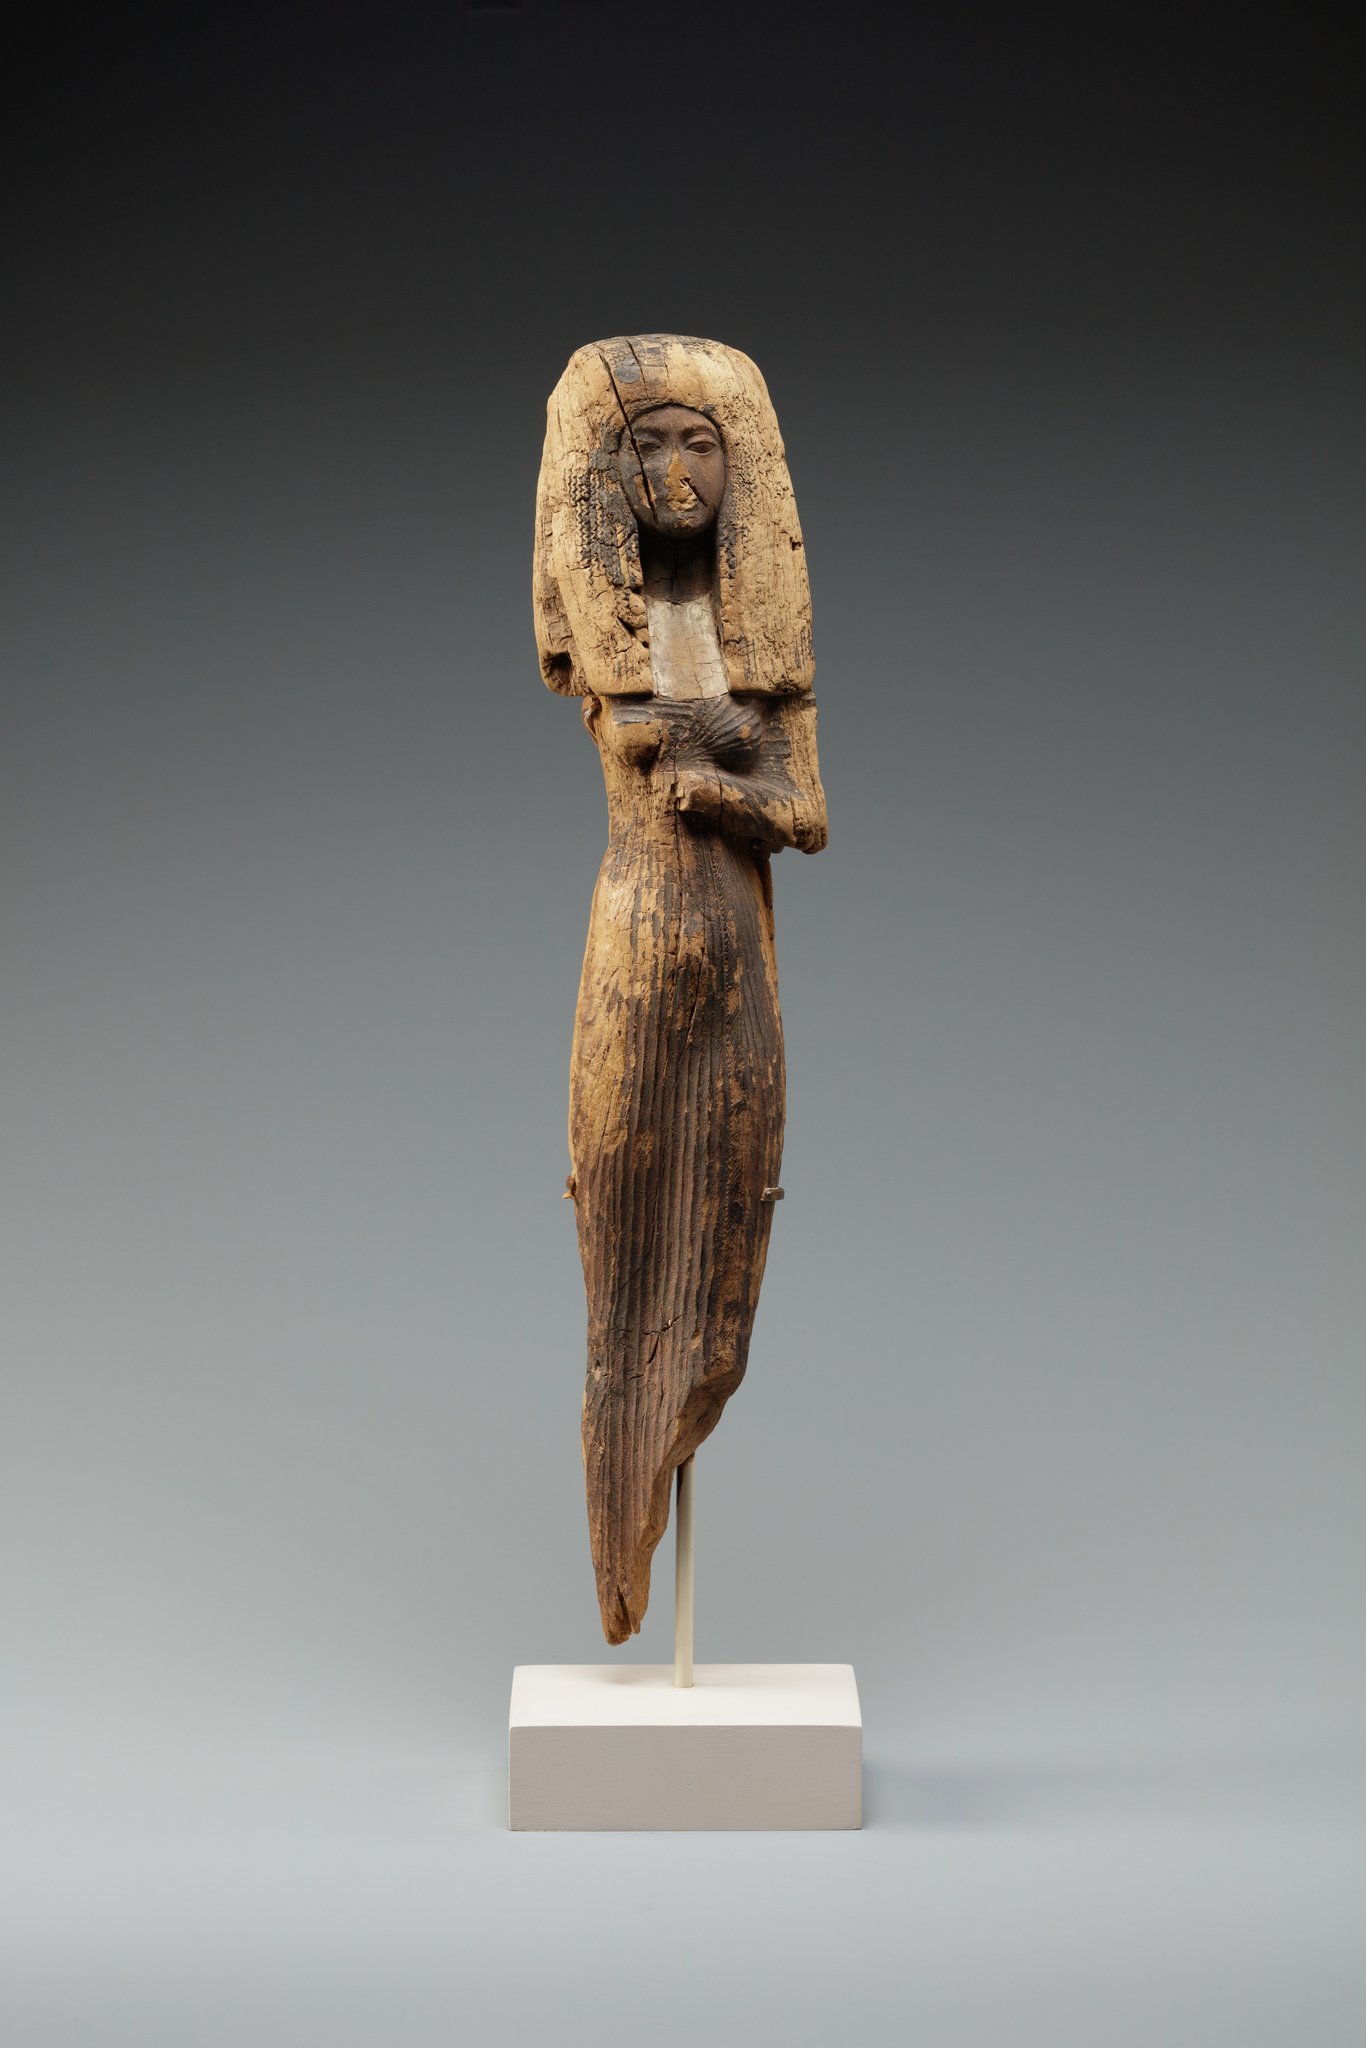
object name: statuette of a woman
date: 1336-1213 BCE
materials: wood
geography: egypt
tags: women